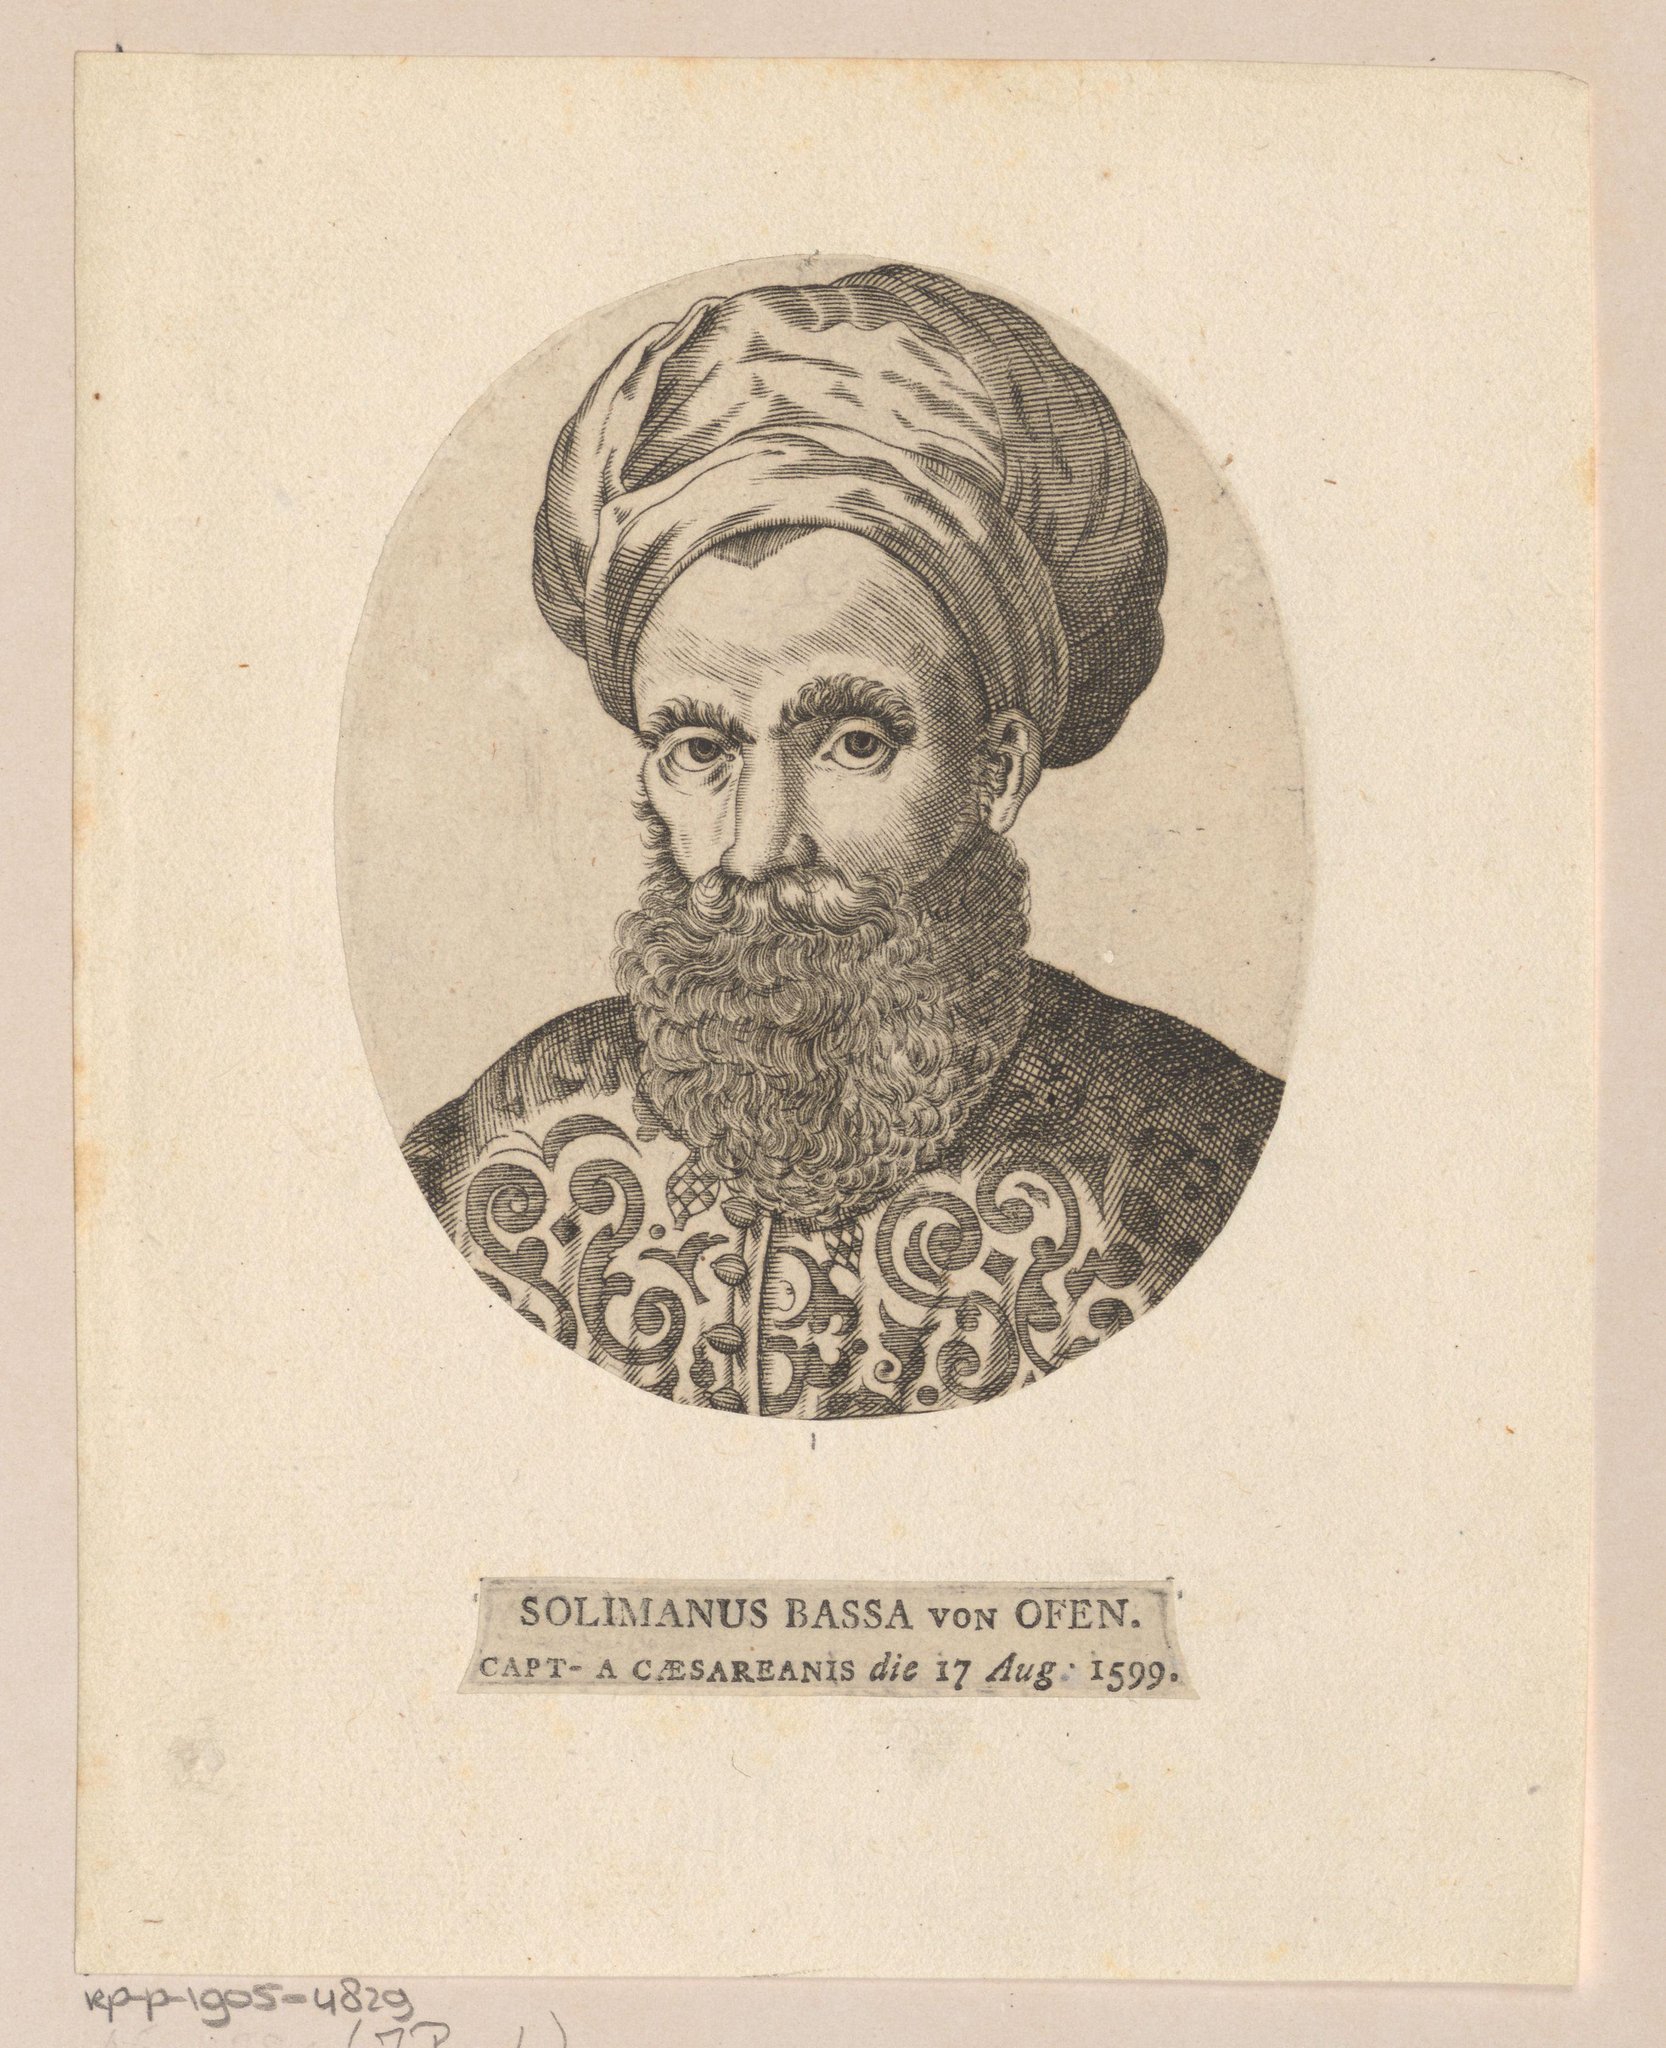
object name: print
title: Portret van Sarı Süleyman Pasha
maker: jan punt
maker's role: draughtsman, print maker, publisher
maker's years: 1711-1779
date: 1726-1777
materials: paper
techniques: engraving, letterpress printing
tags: historical persons, other sovereign (with title)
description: Met tweeregelig onderschrift in het Duits.